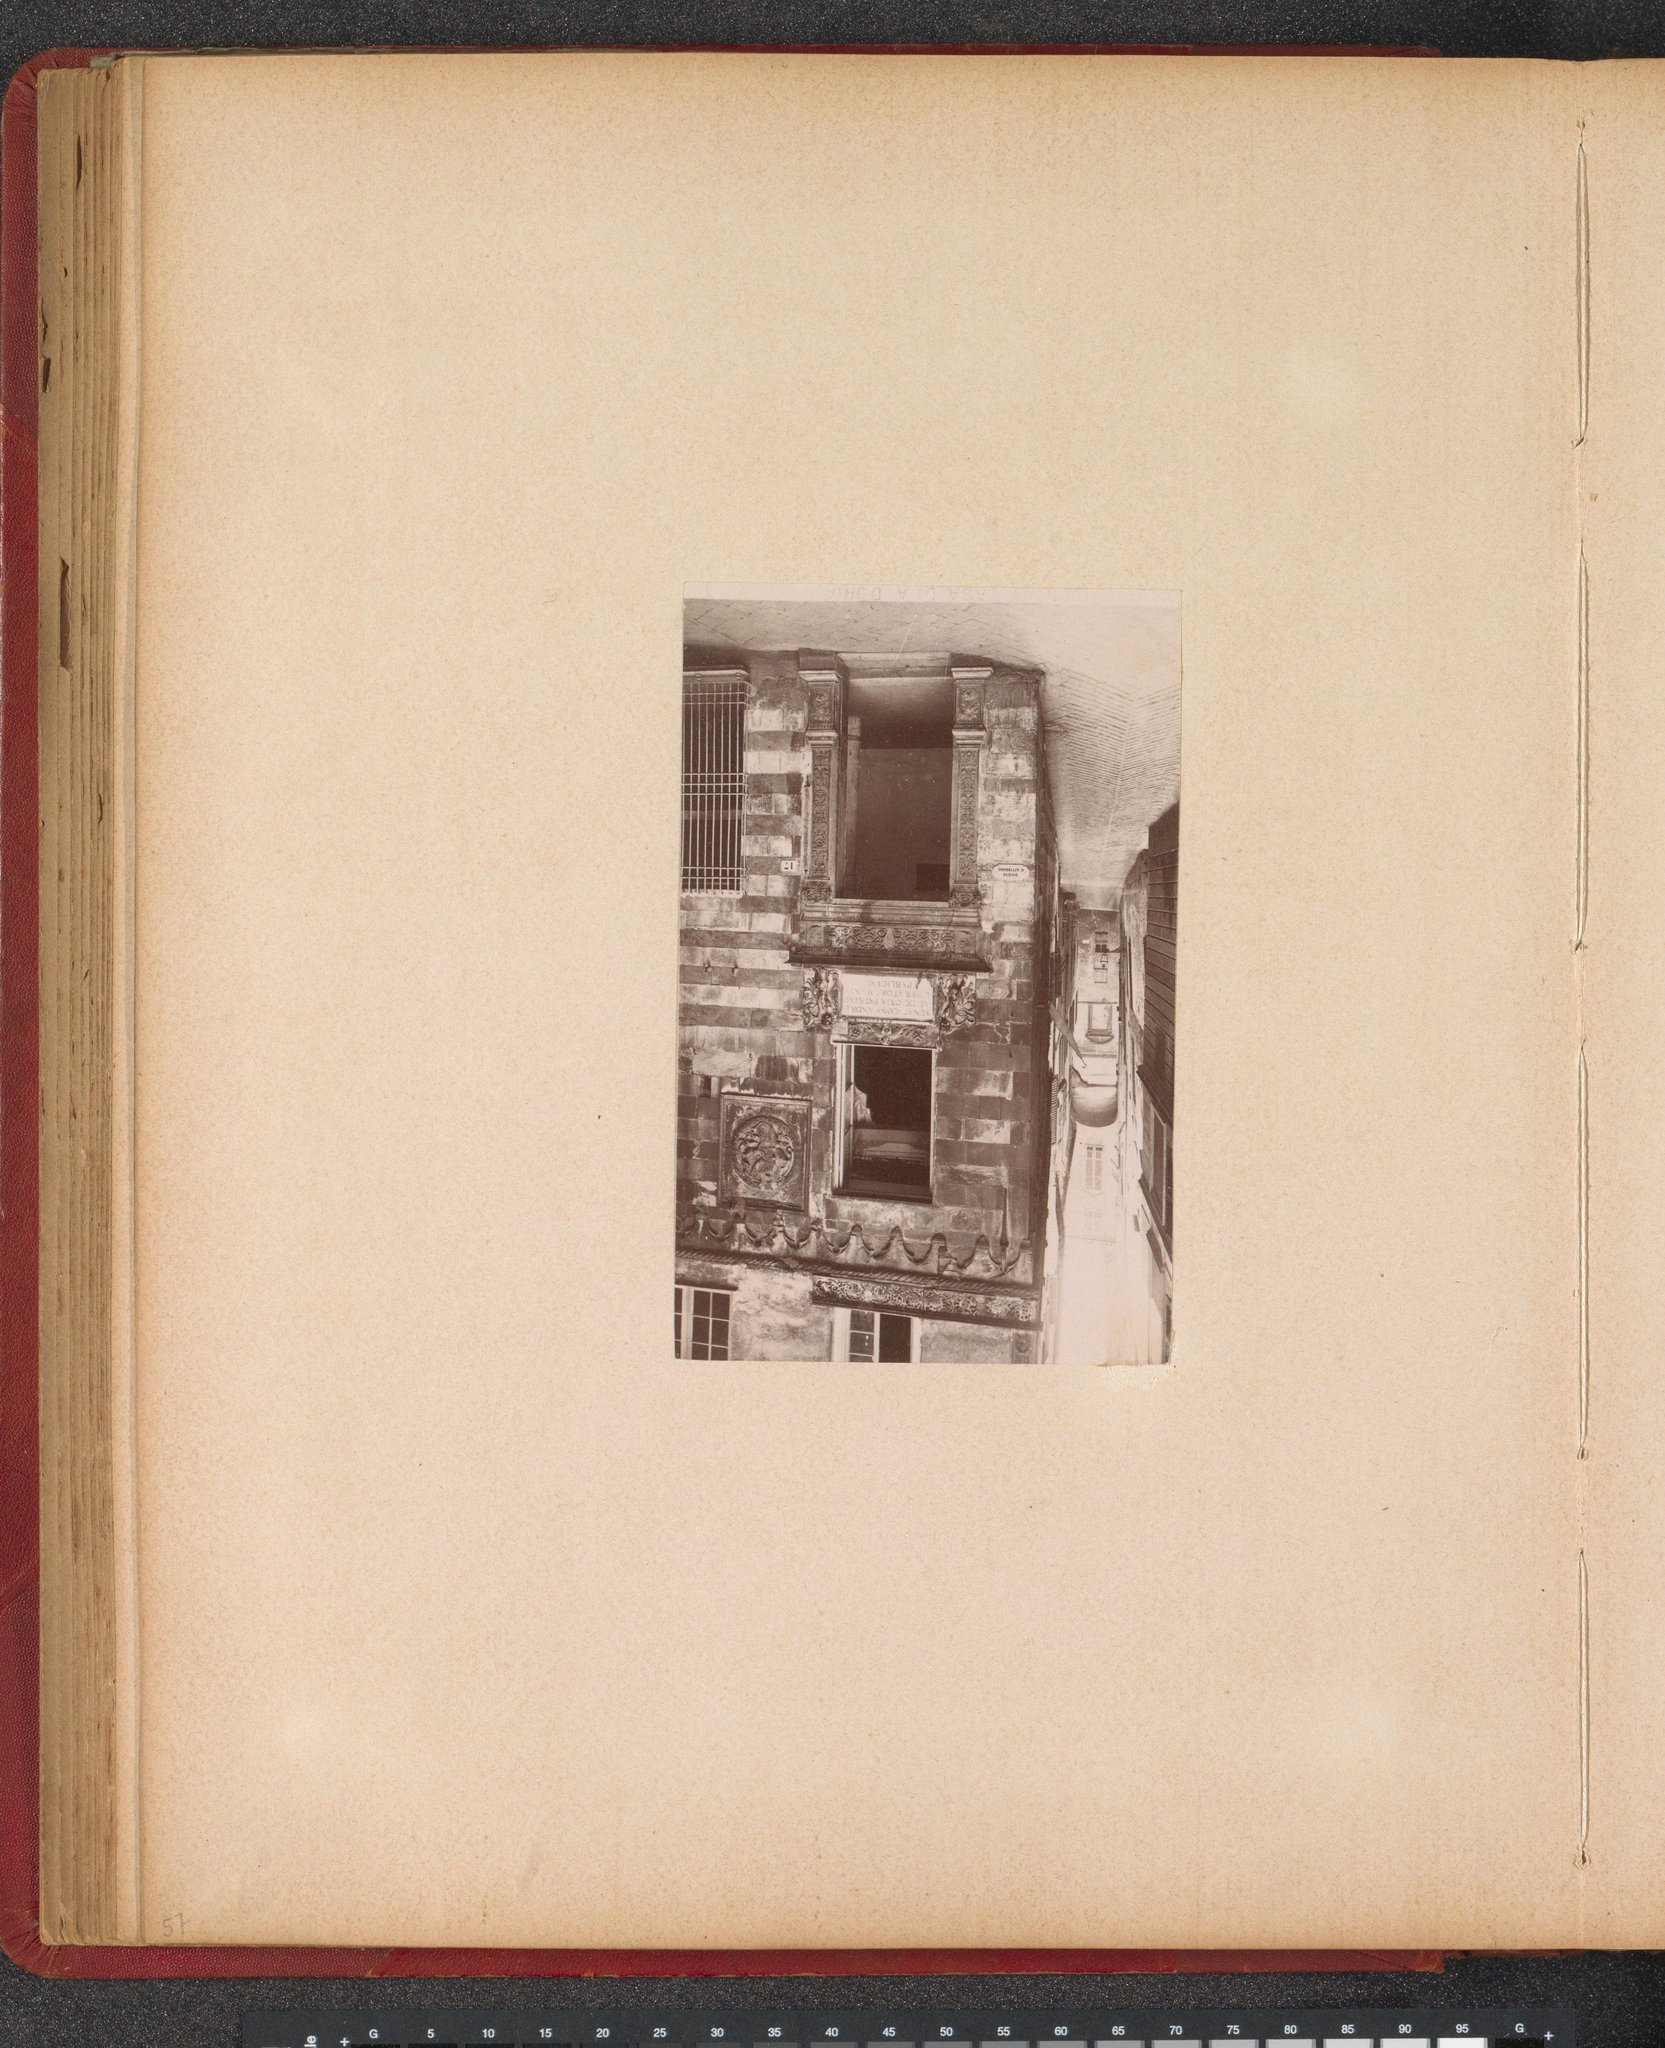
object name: photograph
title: Genova Casa di A. Doria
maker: Anonymous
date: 1870-1900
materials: paper, photographic support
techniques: albumen print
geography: genoa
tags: stone tablet in façade, palace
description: Onderdeel van Reisalbum met foto's van bezienswaardigheden in Italië en Zuid-Frankrijk.